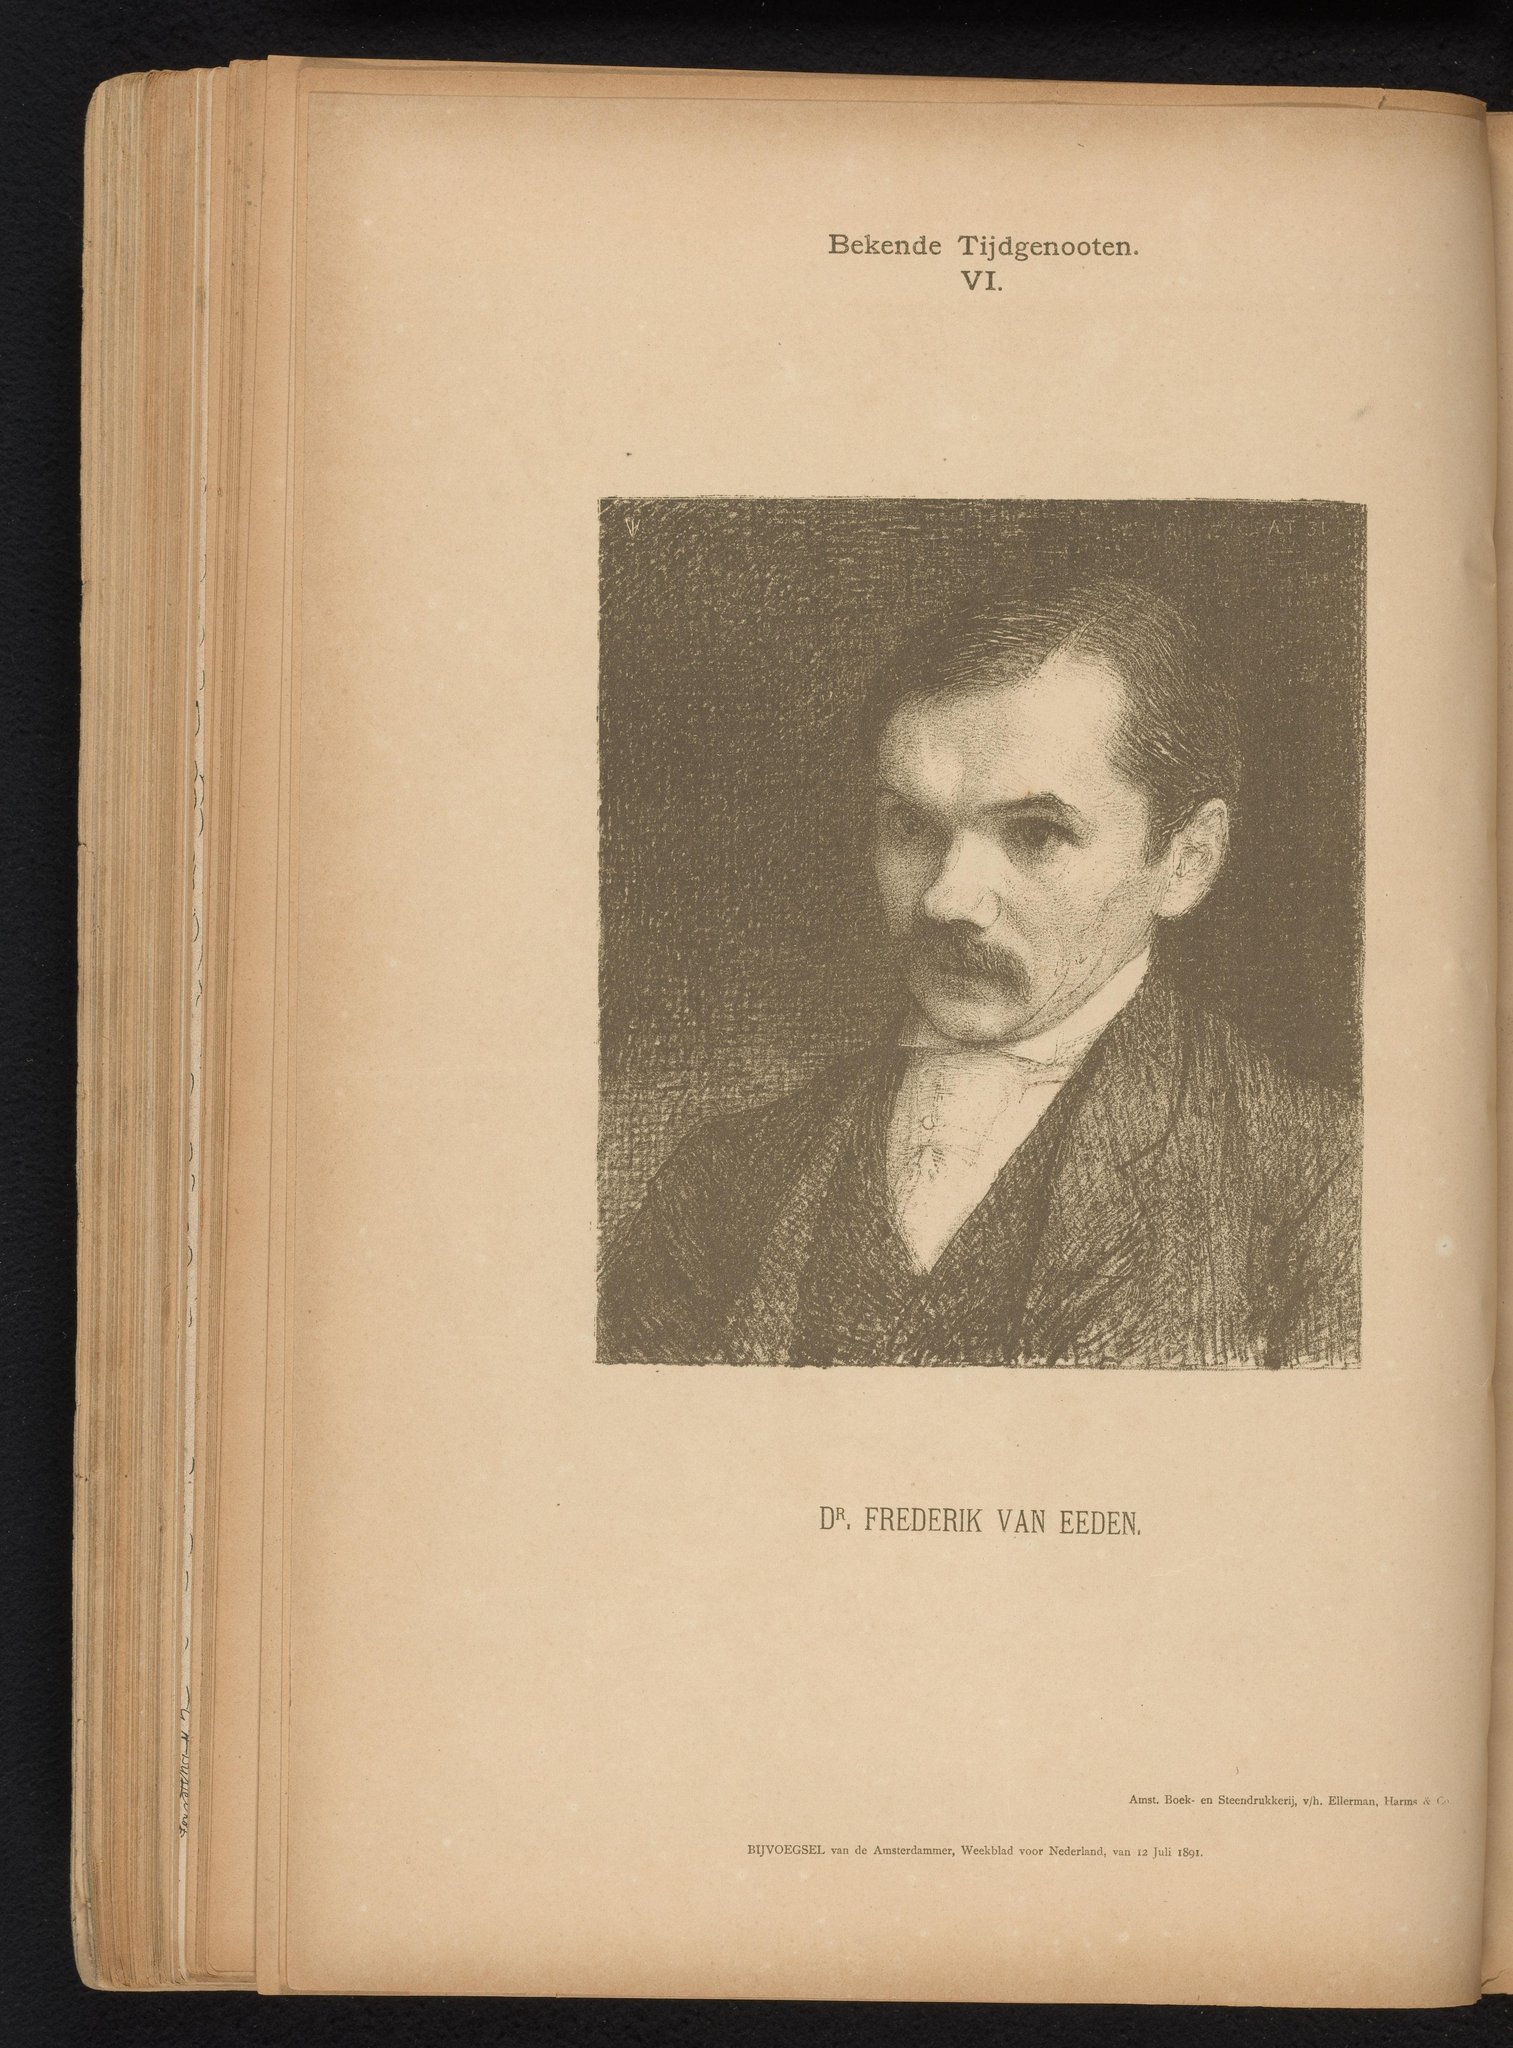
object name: print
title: Bekende Tijdgenooten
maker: jan veth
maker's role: designer, draughtsman, painter, print maker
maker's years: 1864-1925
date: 1891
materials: paper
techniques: lithograph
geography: amsterdam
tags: frederik van eeden, historical persons, portrait of a writer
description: Portret van de schrijver Frederik van Eeden. In de serie 'Bekende Tijdgenooten', nr. VI.